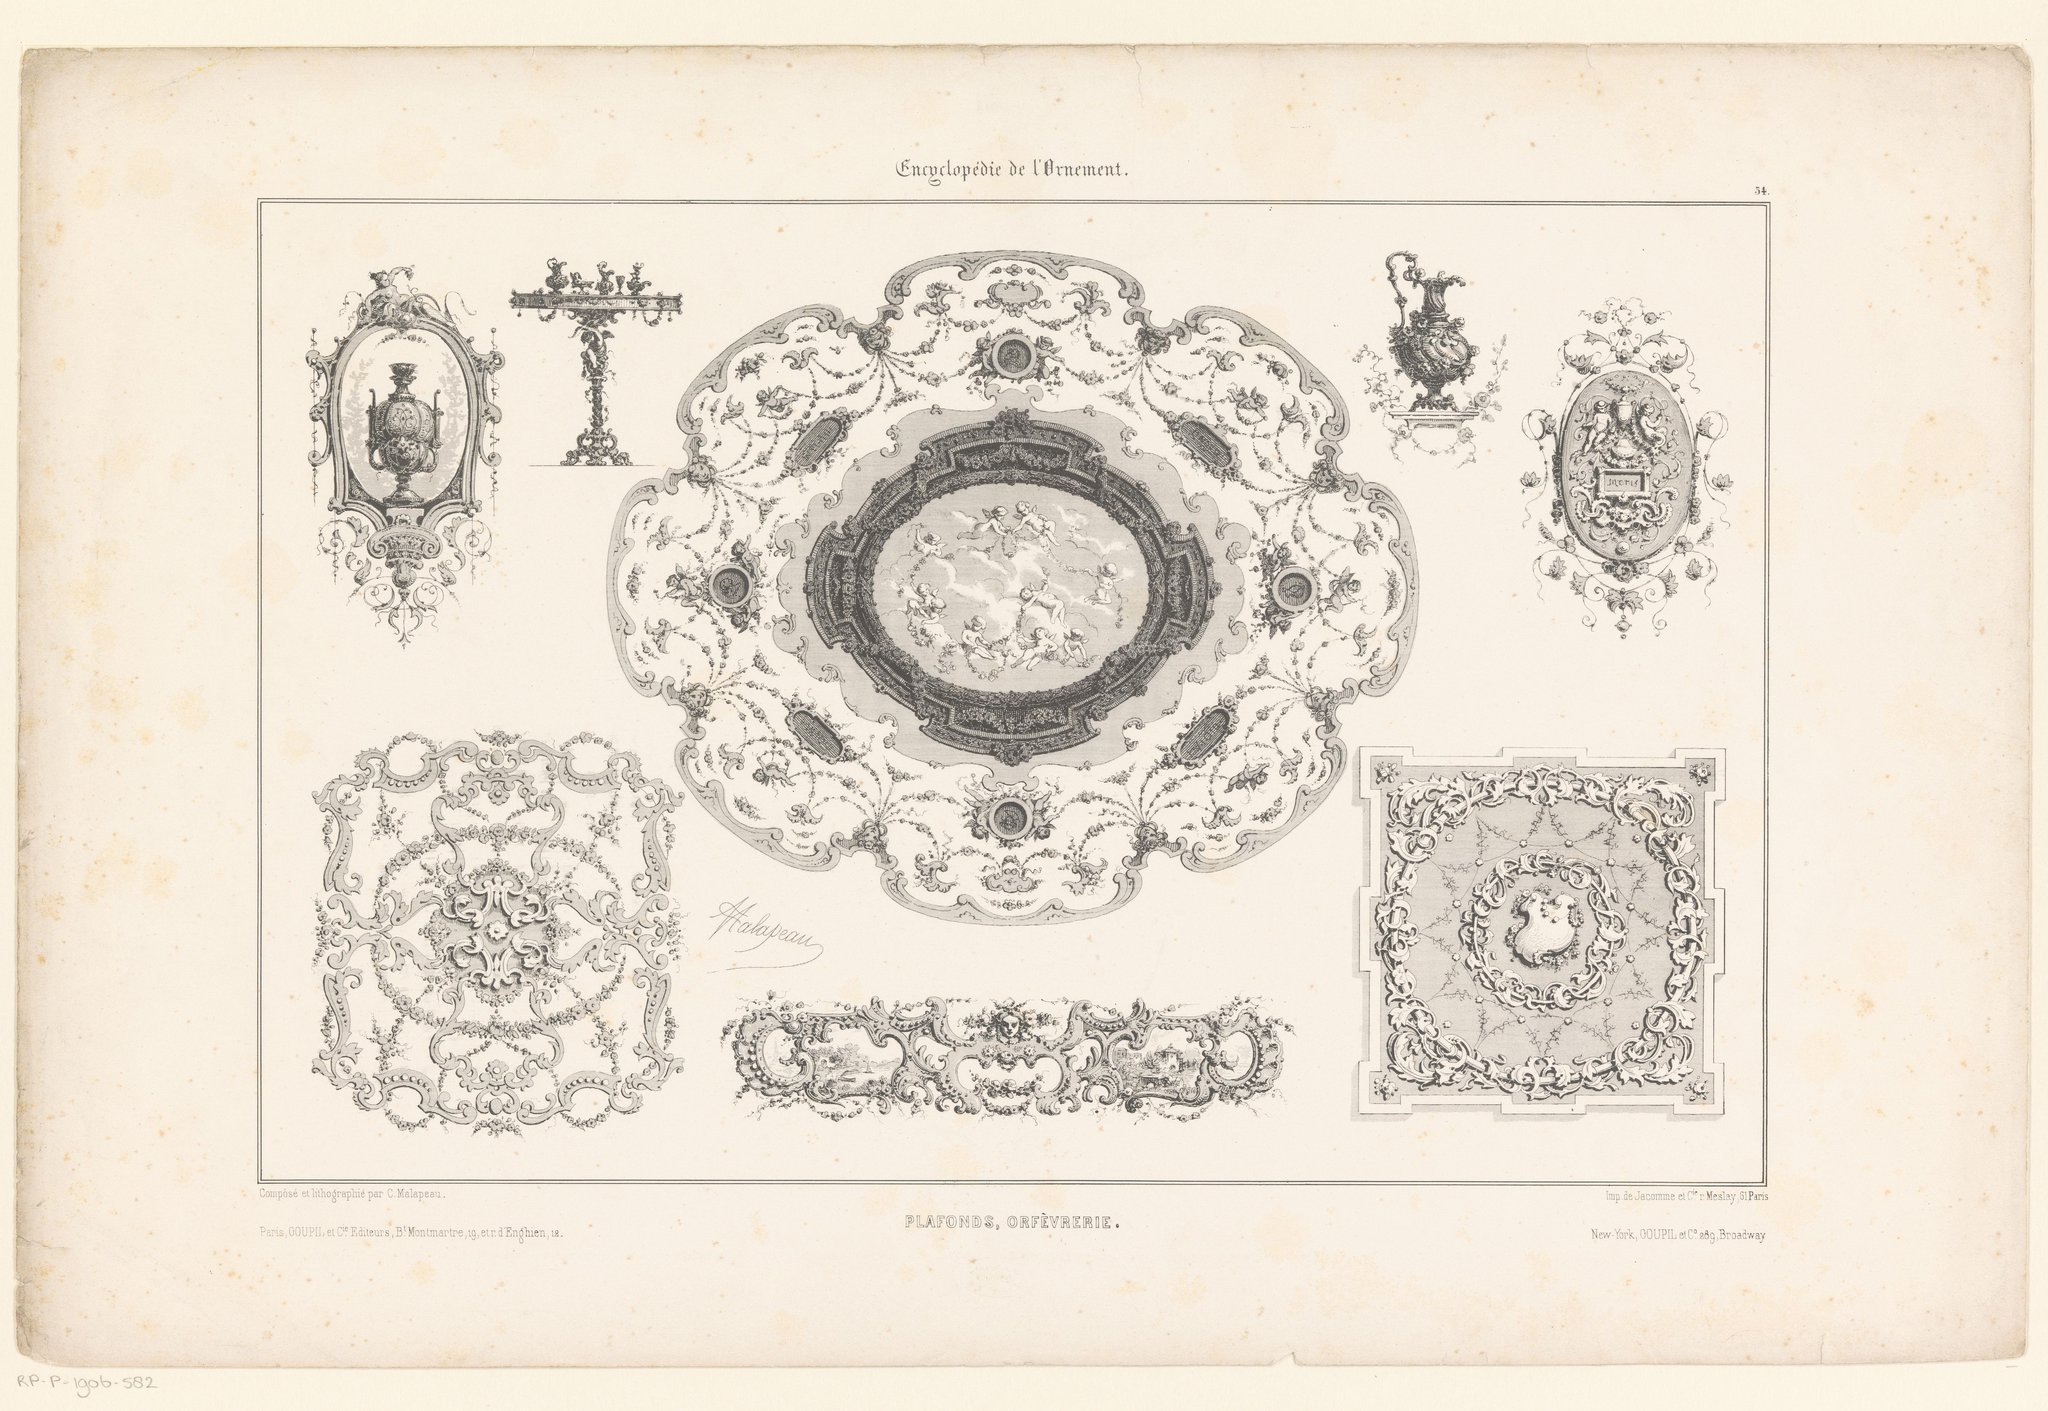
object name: ornament print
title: Encyclopédie de l'Ornement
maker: claude nicolas malapeau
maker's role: print maker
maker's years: 1755-1803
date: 1850-1860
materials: paper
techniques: lithograph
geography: new york city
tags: table-ware, (decorated) ceiling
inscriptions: check stamp: ‘Goupil, Vibert & C / Editeurs / A Paris’, collector's mark: Lugt 2228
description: In het midden een ovaal geornamenteerd plafond met vlechtwerk en putti met guirlandes op wolken. Daaronder drie ornamenten met vlechtwerk, guirlandes en een masker. Links boven een ovaal ornament met een vaas en een geornamenteerde tafel met servies. Rechts boven een geornamenteerde kan en een ovaal ornament met vlechtwerk en putti aan weerszijden van een vaas.